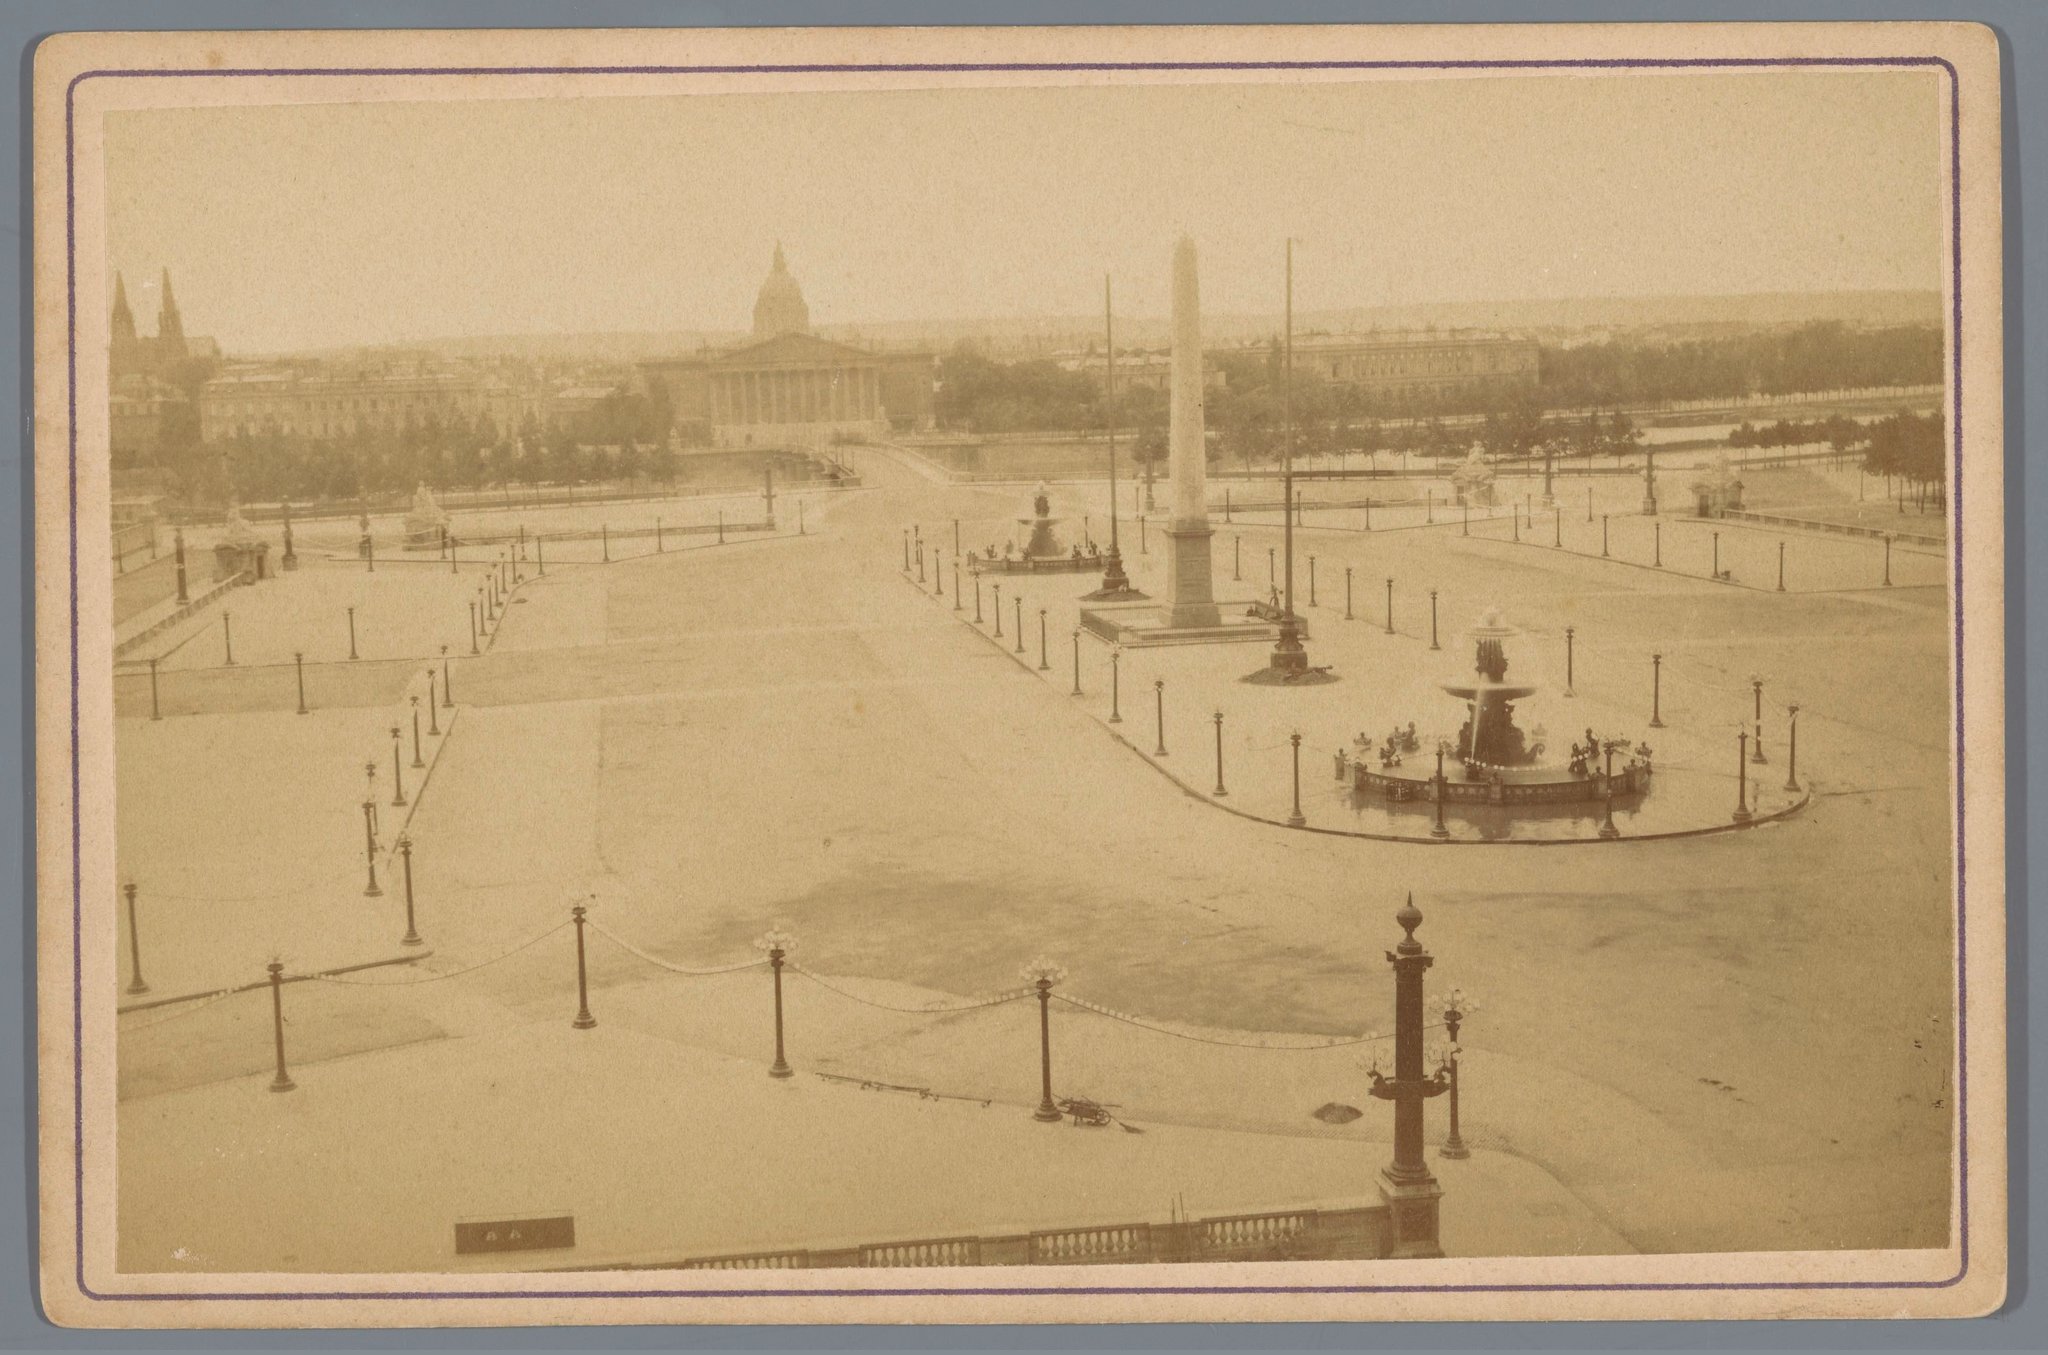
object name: cabinet photograph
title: Gezicht op de Place de la Concorde te Parijs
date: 1865-1875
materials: cardboard, photographic support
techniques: albumen print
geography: paris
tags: square, place, circus, etc., obelisk, needle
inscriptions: inscription: ‘Place de la Concorde’, inscription: ‘Compagnie Photographique Debitte & Hervé 170, Rue de Rivoli, Paris’